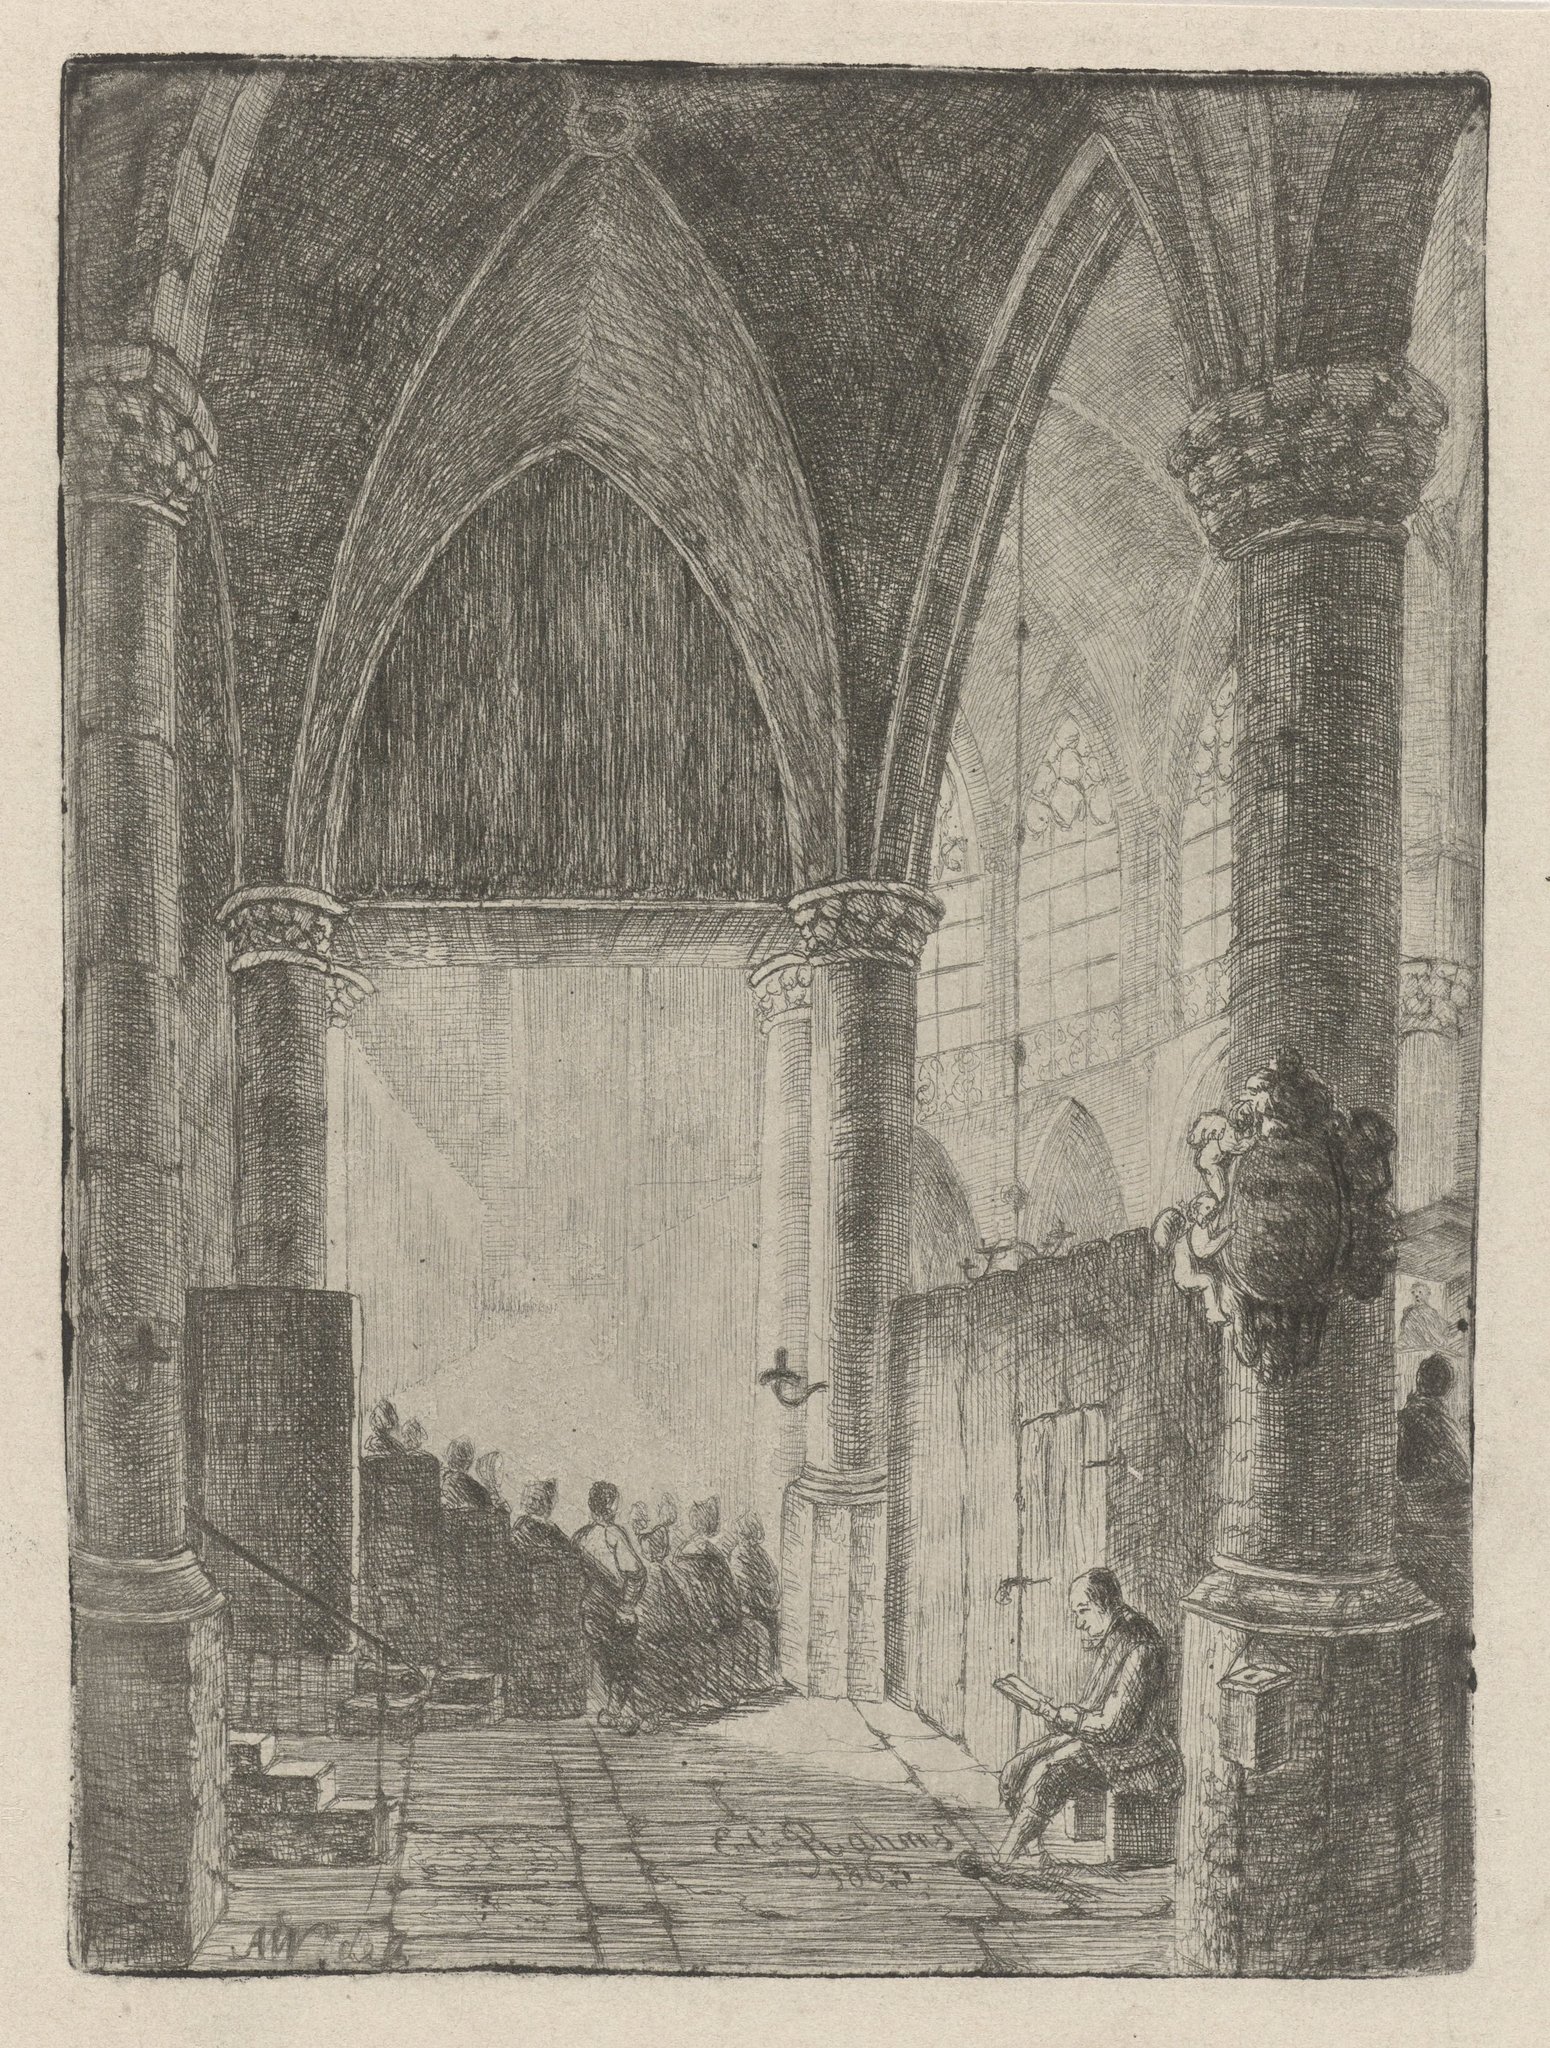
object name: print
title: Kerkdienst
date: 1863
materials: paper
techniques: etching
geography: oudewater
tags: interior of church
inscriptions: collector's mark: Lugt 2228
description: Gezicht op een kerkinterieur waar een kerkdienst wordt gehouden. Op de voorgrond zit een man te lezen.